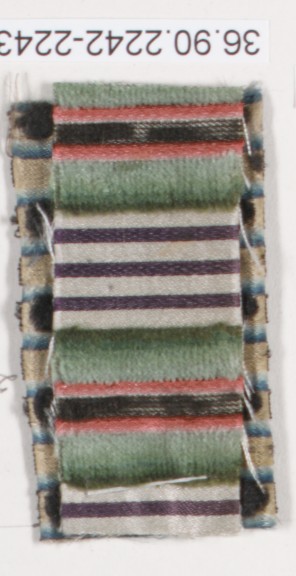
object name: piece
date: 1801-1900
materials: silk